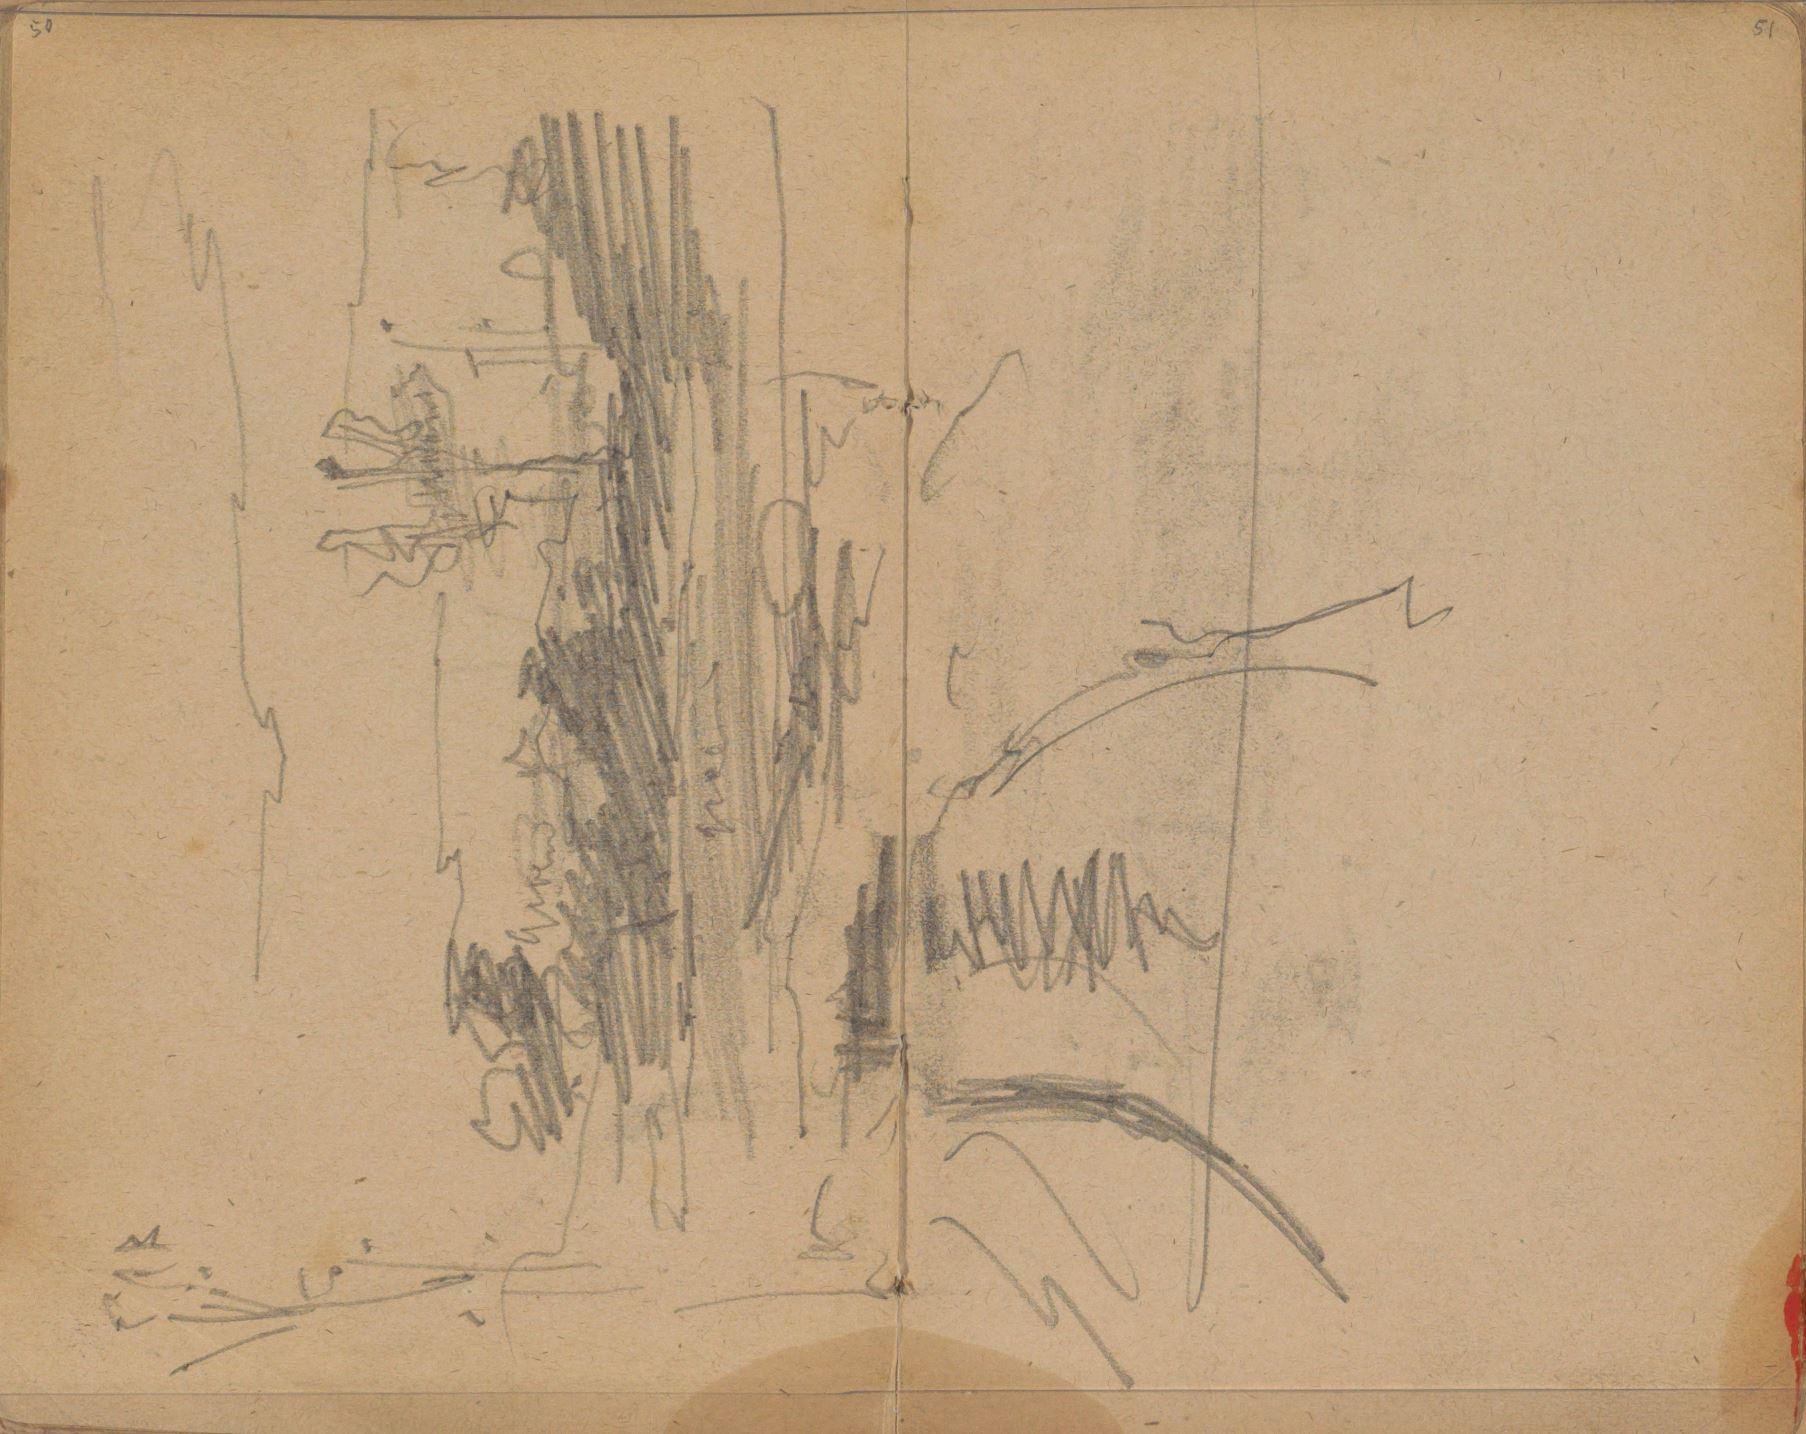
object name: sketchbook leaf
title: Landschap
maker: george hendrik breitner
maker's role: draughtsman, painter, print maker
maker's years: 1857-1923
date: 1881-1883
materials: paper, pencil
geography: south holland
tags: landscapes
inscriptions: kleurnotitie, handgeschreven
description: Landschap. Pagina 50 en pagina 51 uit een schetsboek met 70 bladen.